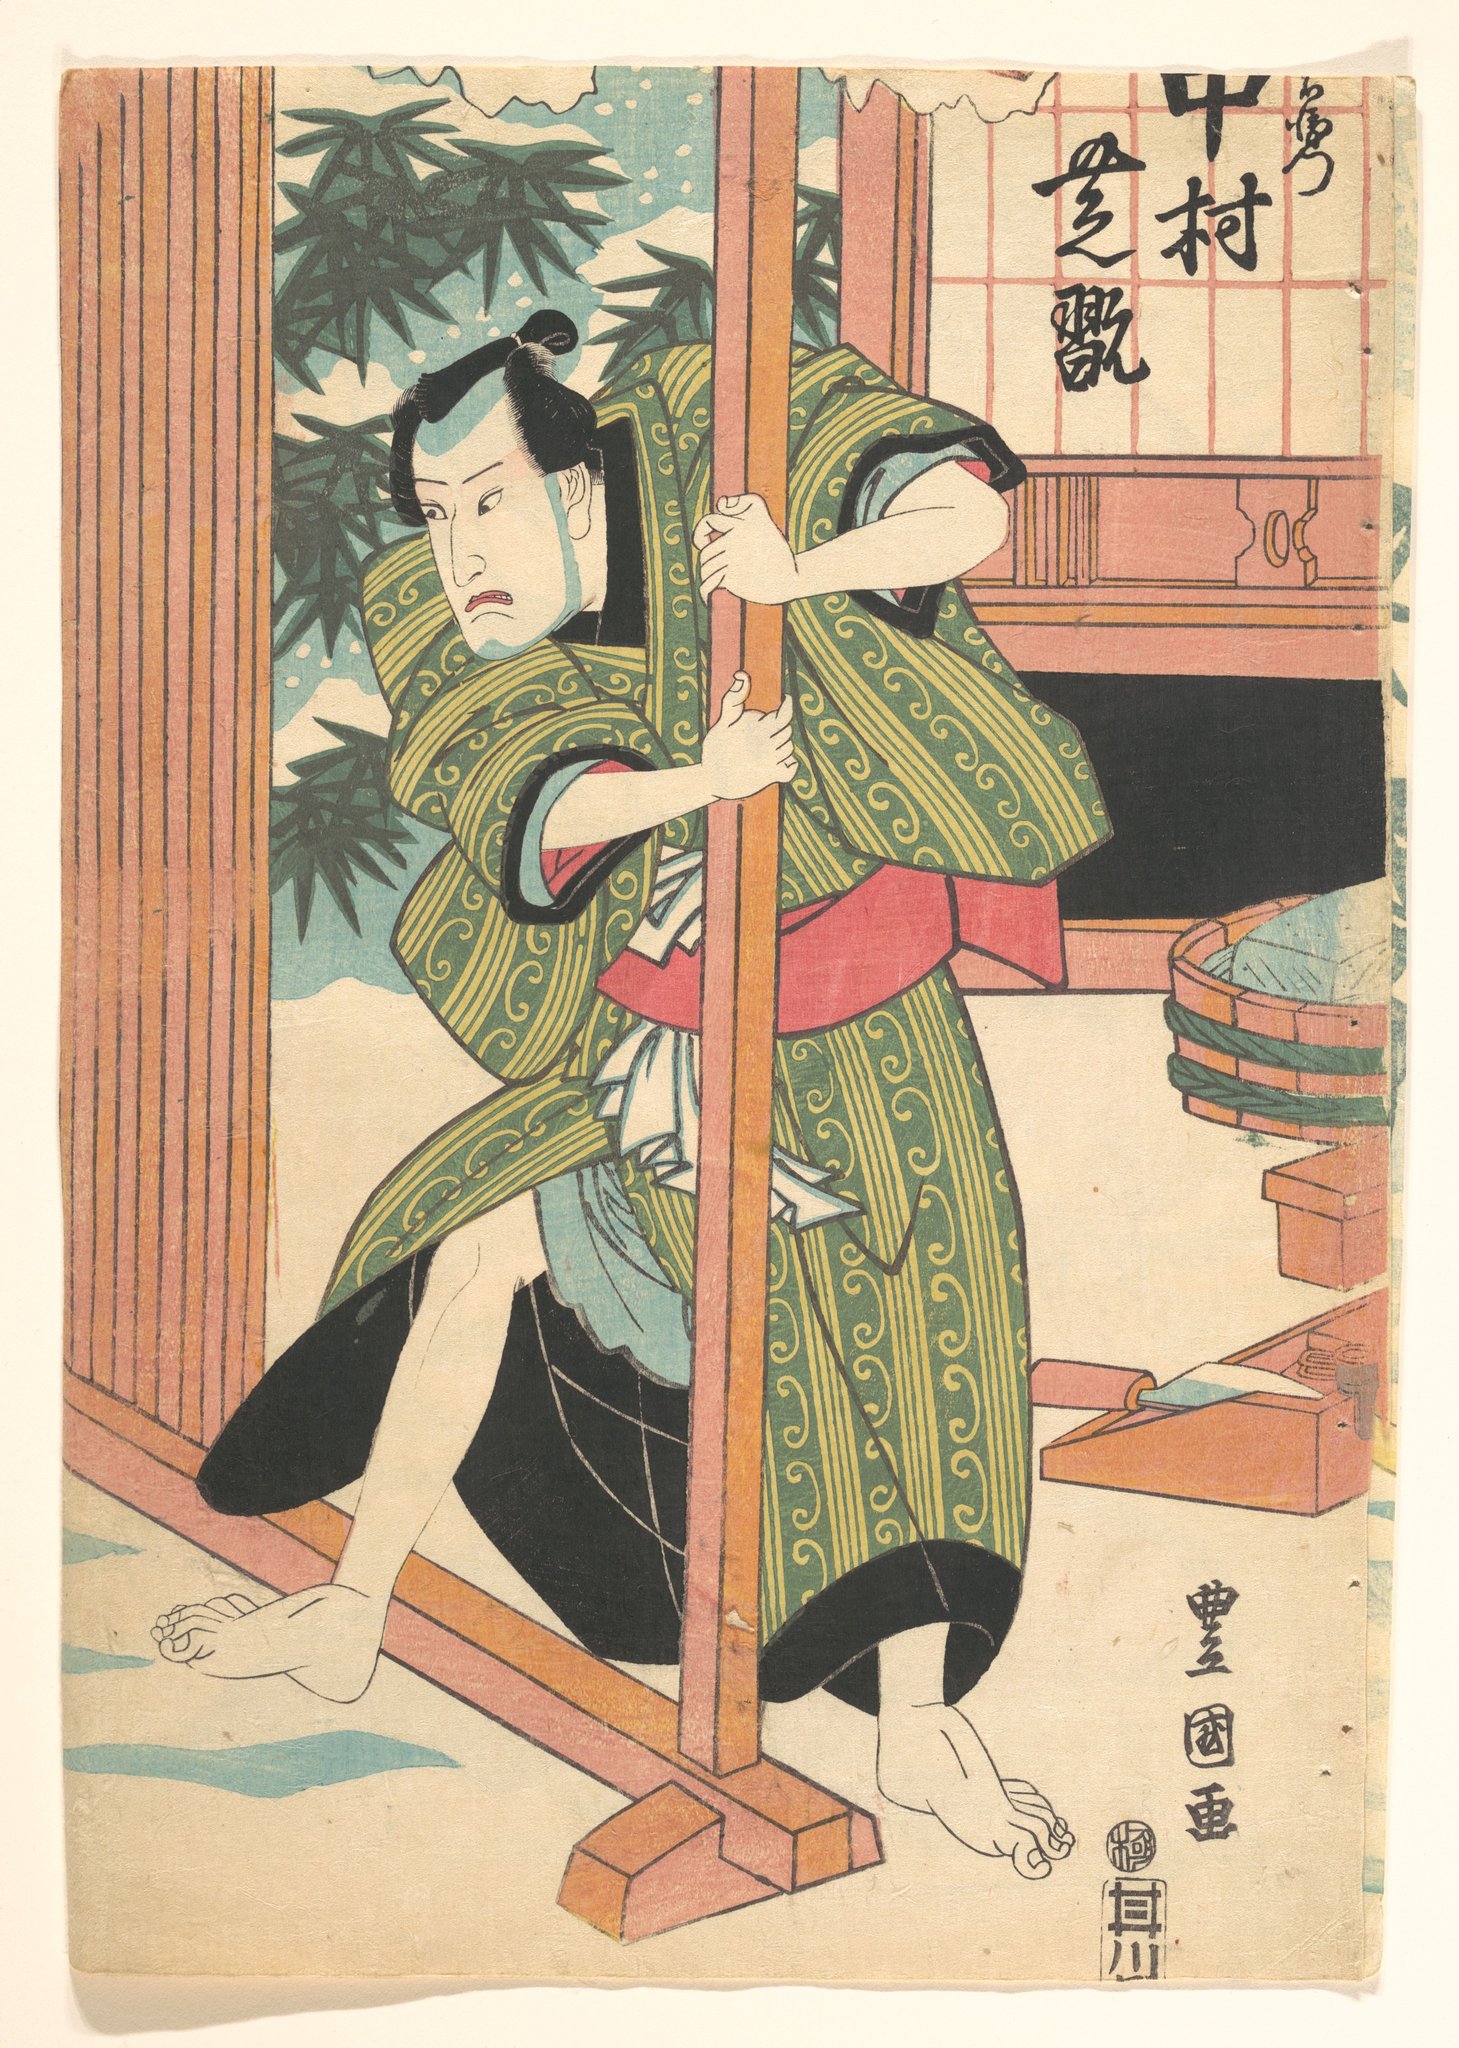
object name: print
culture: japanese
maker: utagawa kunisada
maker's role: artist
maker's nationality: japanese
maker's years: 1786-1864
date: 1801-1900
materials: ink, paper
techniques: woodblock print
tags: men